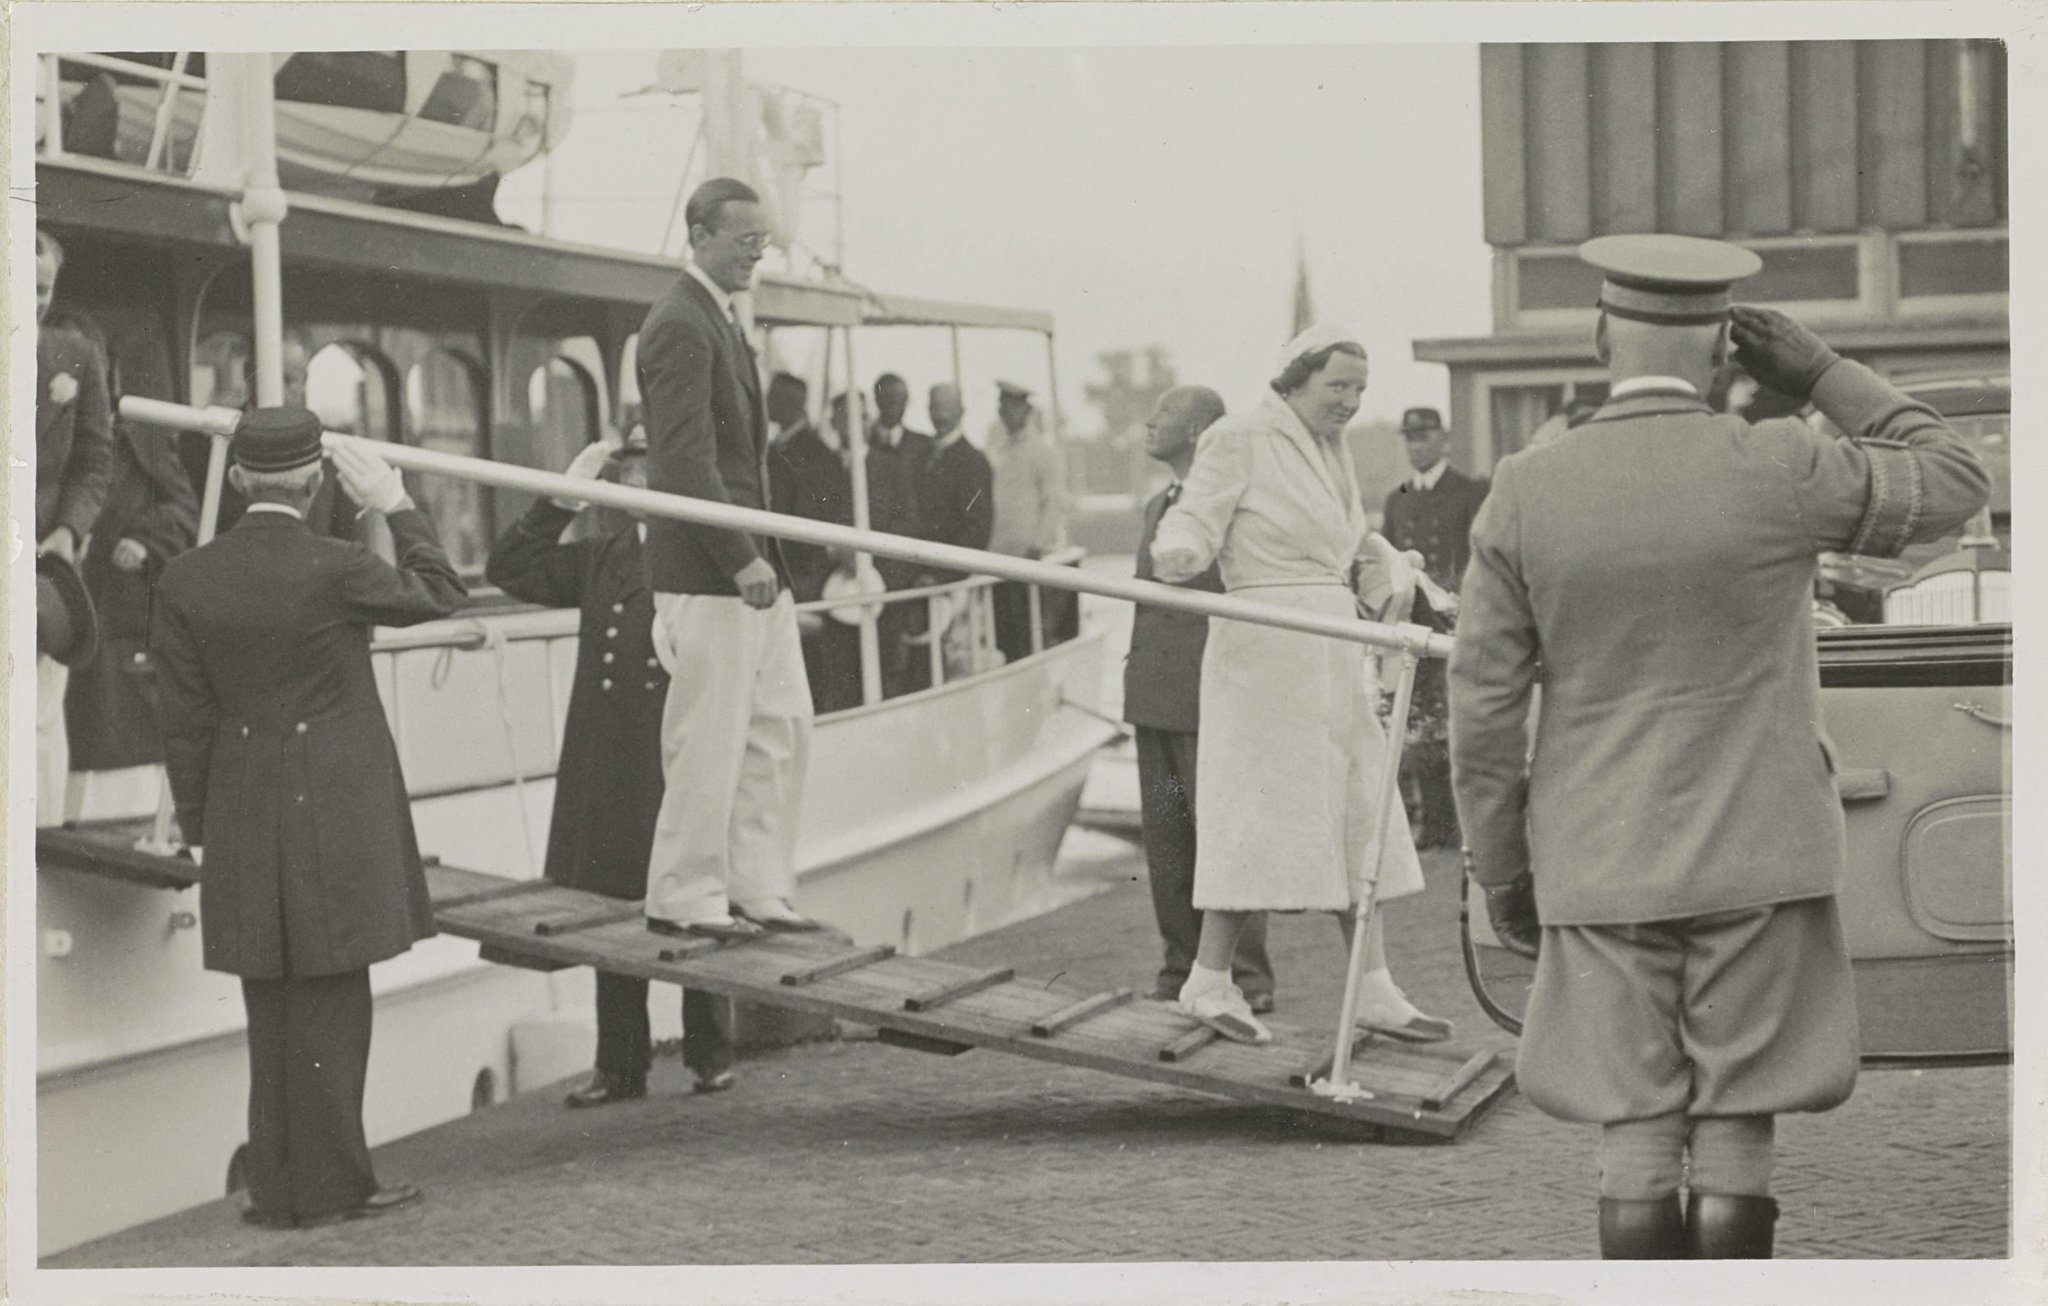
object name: ansichtkaart, prentbriefkaart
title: Bezoek van Juliana, koningin der Nederlanden, en Bernhard van Lippe-Biesterfeld aan het prinsenjacht Hr. Ms. 'Piet Hein' te Muiden op 28 augustus 1937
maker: Anonymous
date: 1937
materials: photographic support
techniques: photography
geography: netherlands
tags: bernhard (prins der nederlanden), juliana of the netherlands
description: De hier vermelde titel verwijst naar de hoogst verkregen titel van de geportretteerde, niet per se naar de titel die de geportretteerde op deze voorstelling draagt.